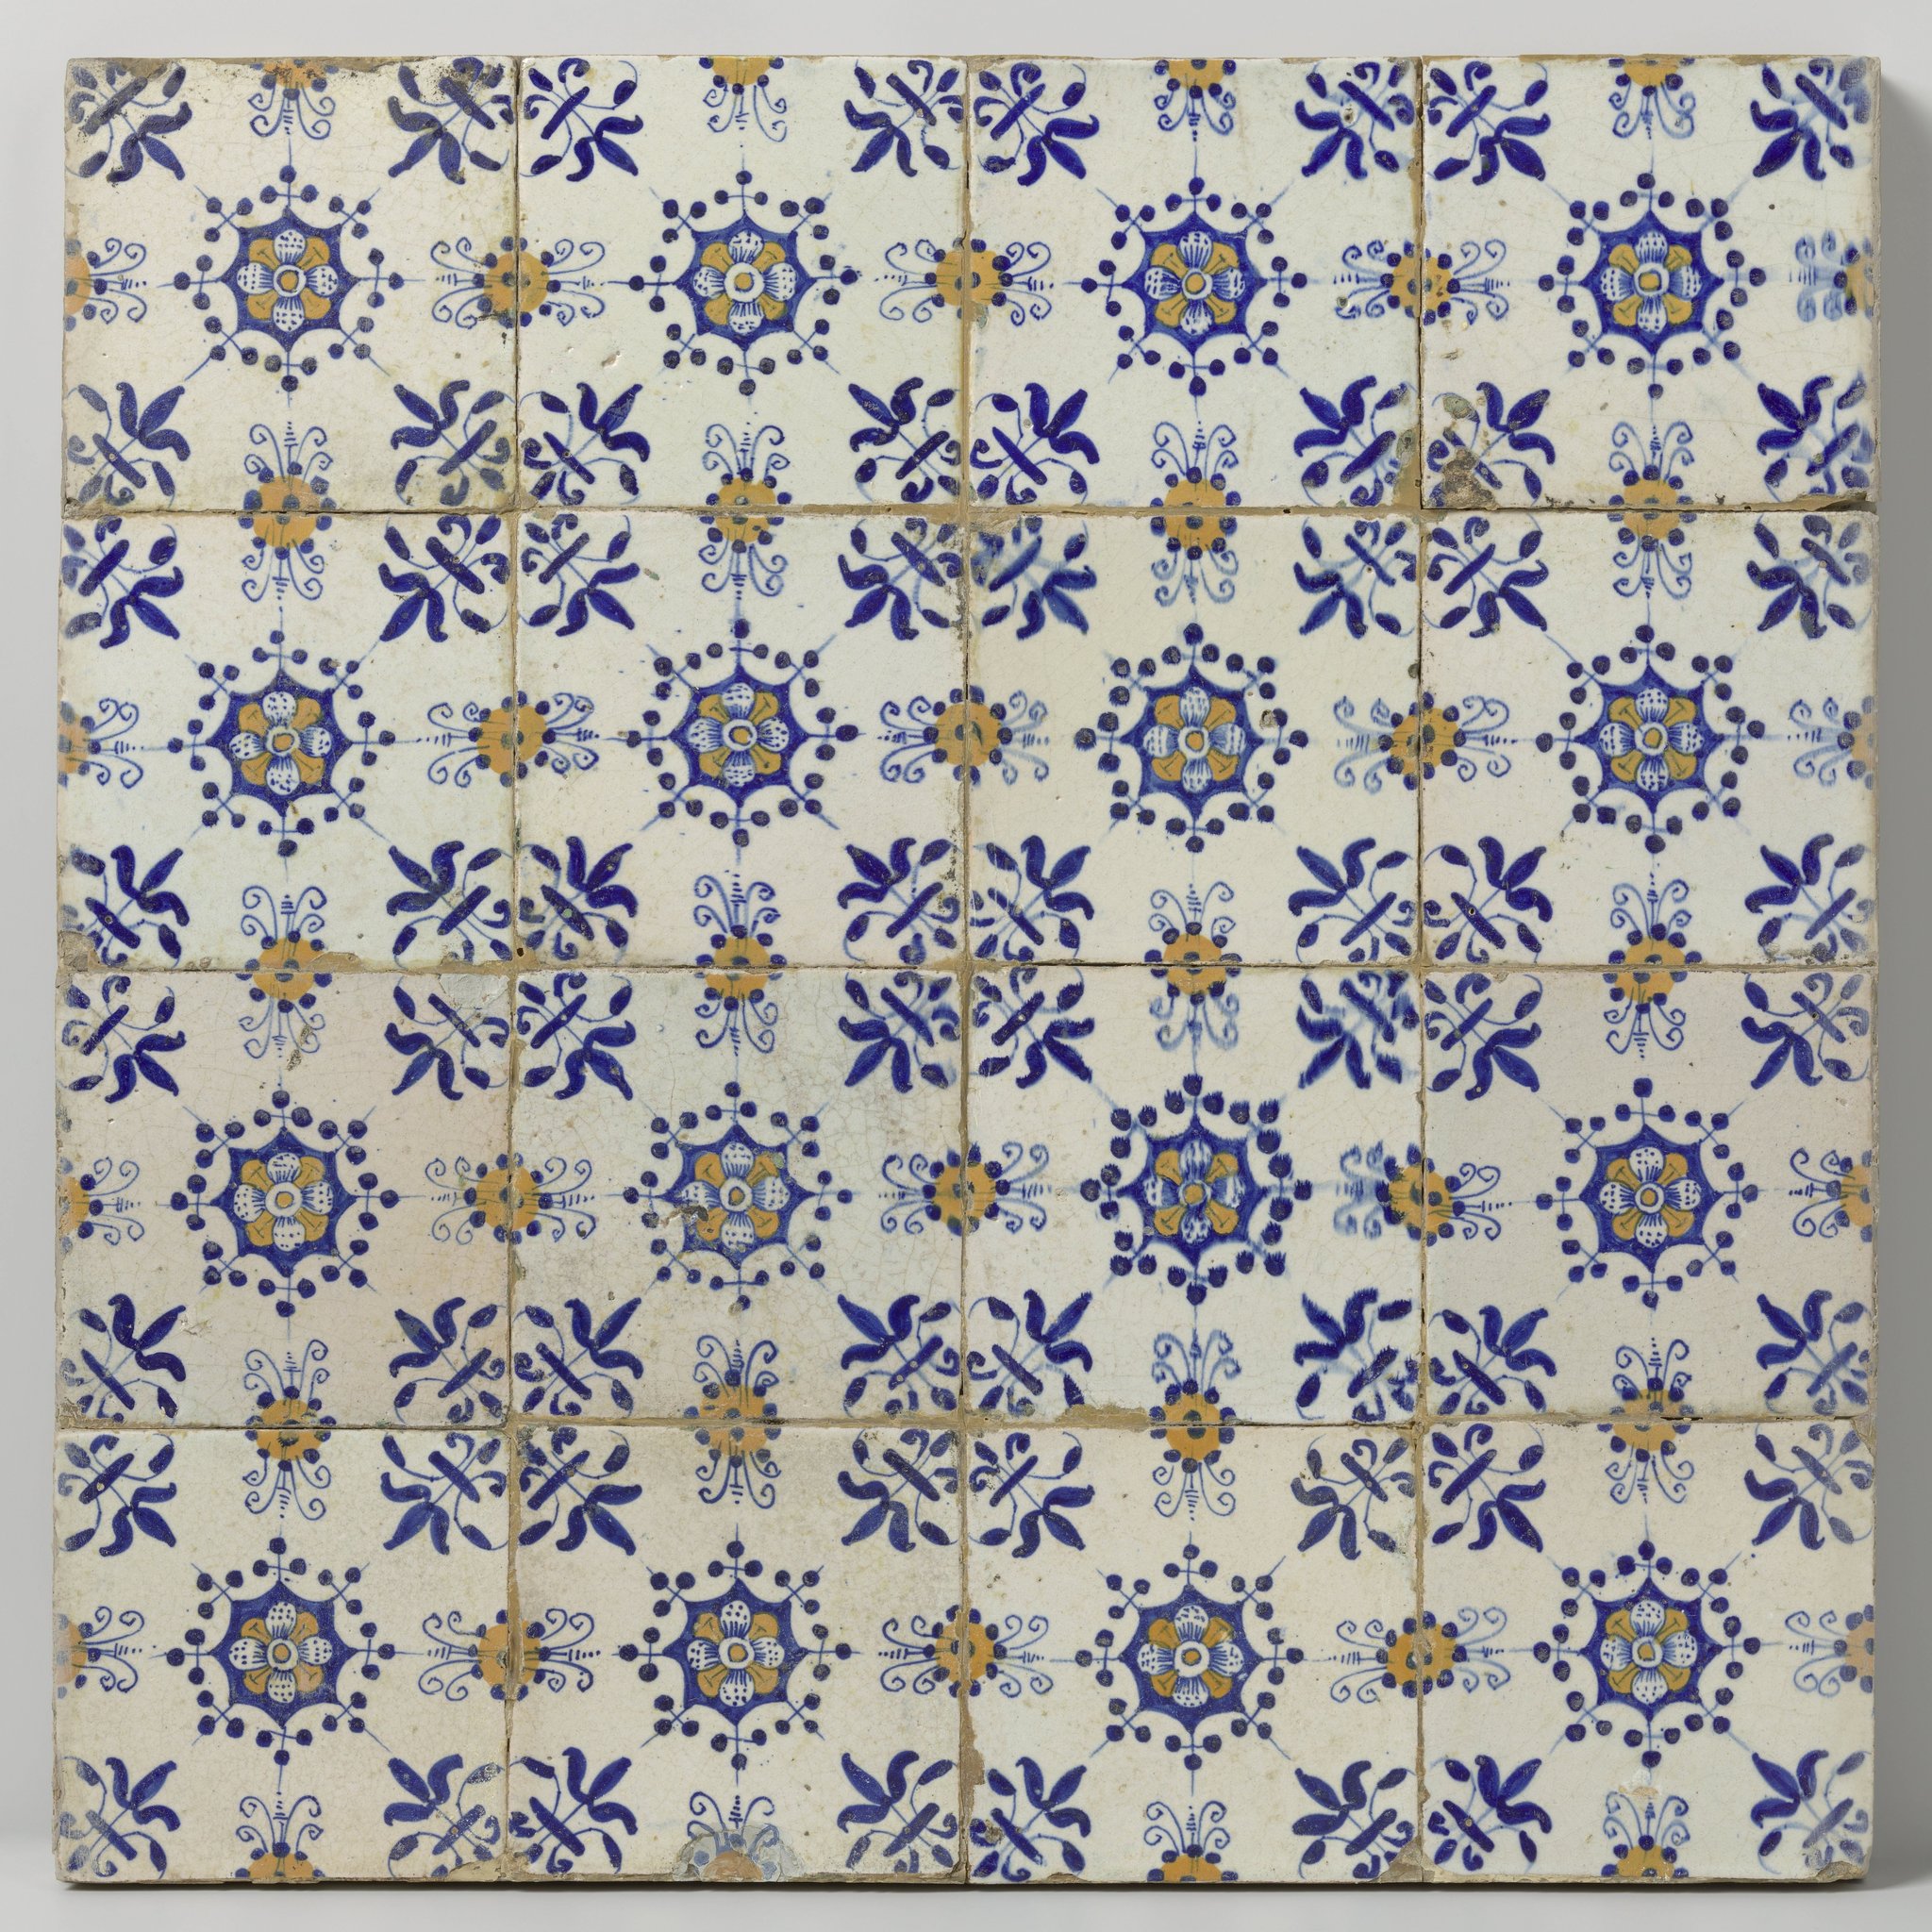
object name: tegelveld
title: Veld van zestien tegels (4x4) elk met een veelkleurig patroon in blauw, geel en oranje van een rozet omgeven door drie stippen met in de hoeken een lelie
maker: Anonymous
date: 1640-1660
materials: earthenware, glaze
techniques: maiolica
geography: haarlem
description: Veld van zestien tegels (4 x 4) elk met een veelkleurige (blauw, geelen oranje) rozet omgeven door driestippen met in de hoeken een lelie.